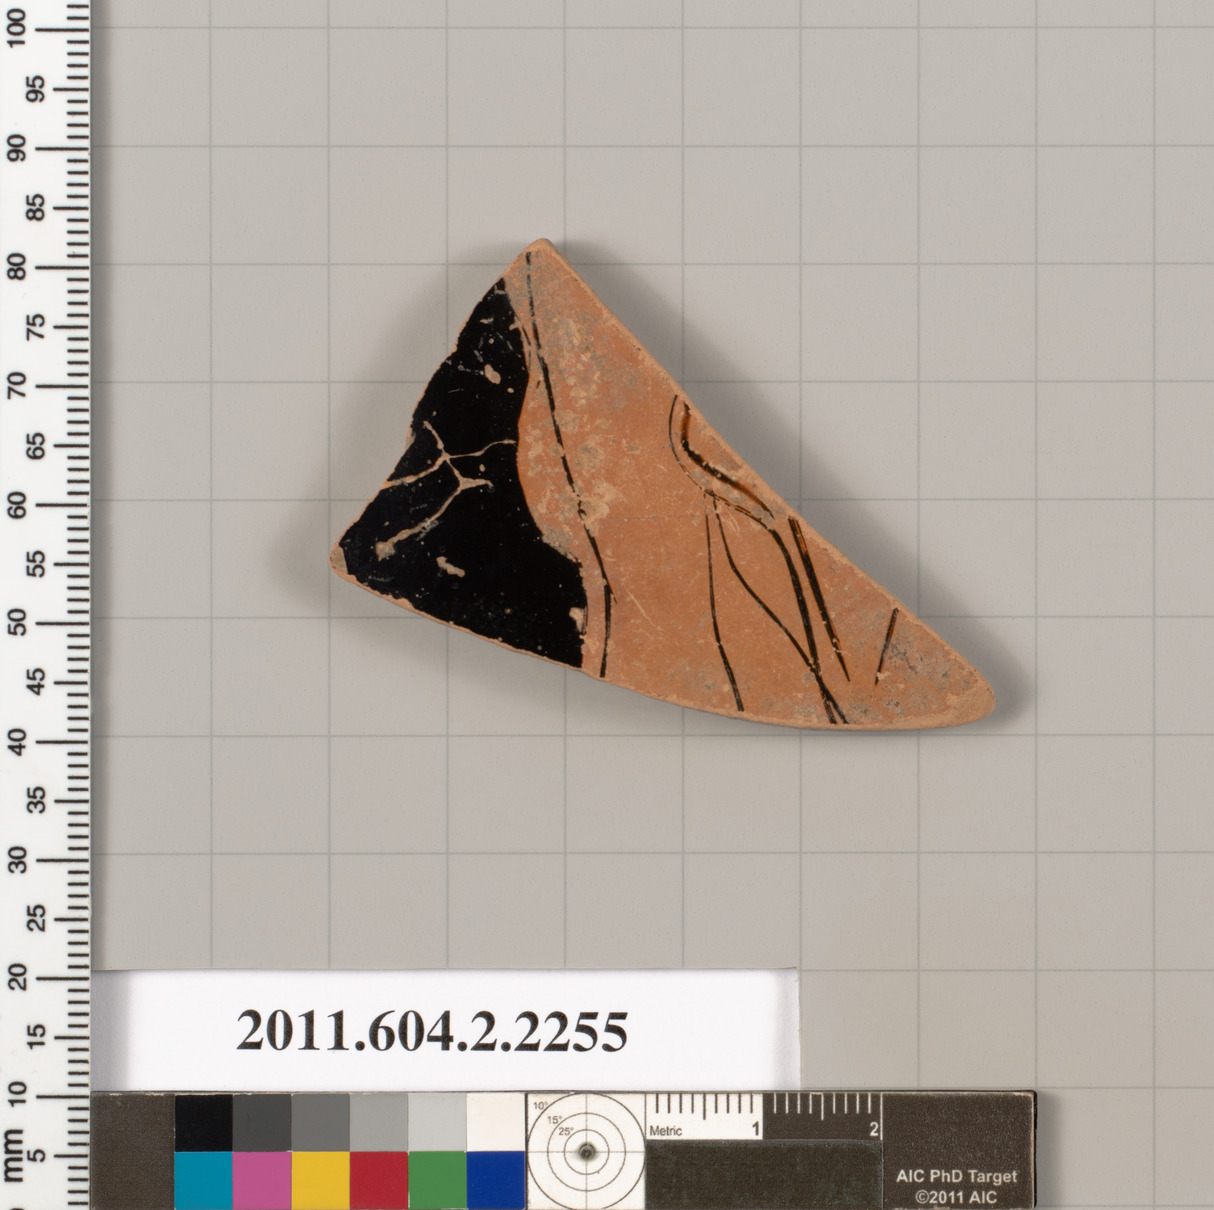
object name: pot fragment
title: Terracotta fragment of a pot; unglazed on the inside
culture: greek, attic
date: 490-470 BCE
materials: terracotta